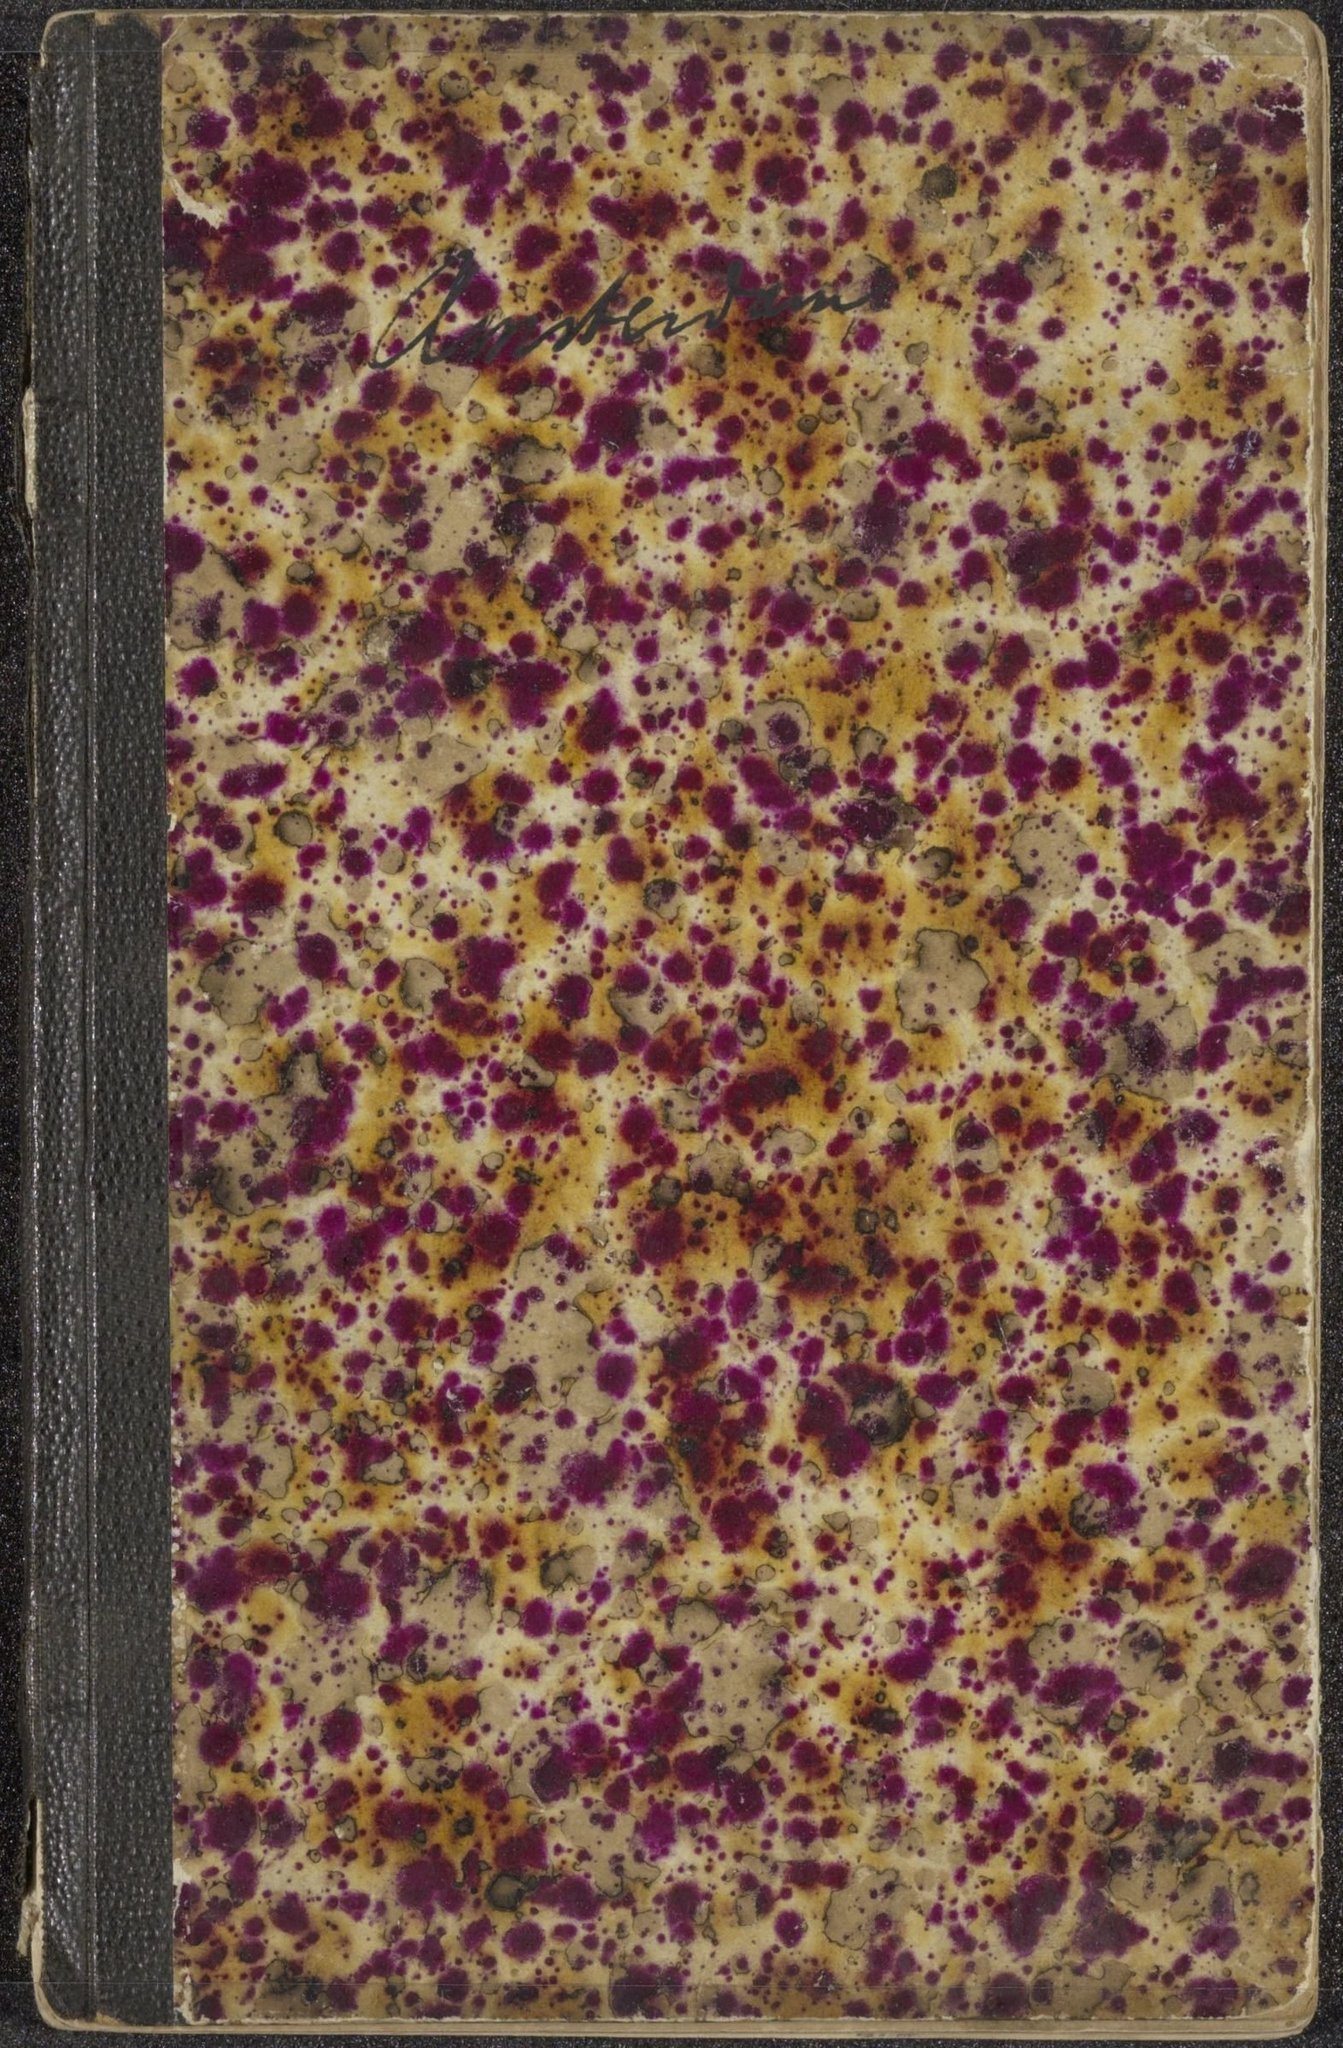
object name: sketchbook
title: Schetsboek met 14 bladen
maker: george hendrik breitner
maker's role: draughtsman, painter, print maker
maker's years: 1857-1923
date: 1886-1923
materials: cardboard, chalk, linen, paper, pencil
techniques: marbling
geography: amsterdam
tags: adult woman, adult man, street, amsterdam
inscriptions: annotation: ‘Amsterdam’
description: Schetsboek bestaande uit 14 bladen met figuurstudies en gezichten in Amsterdam.